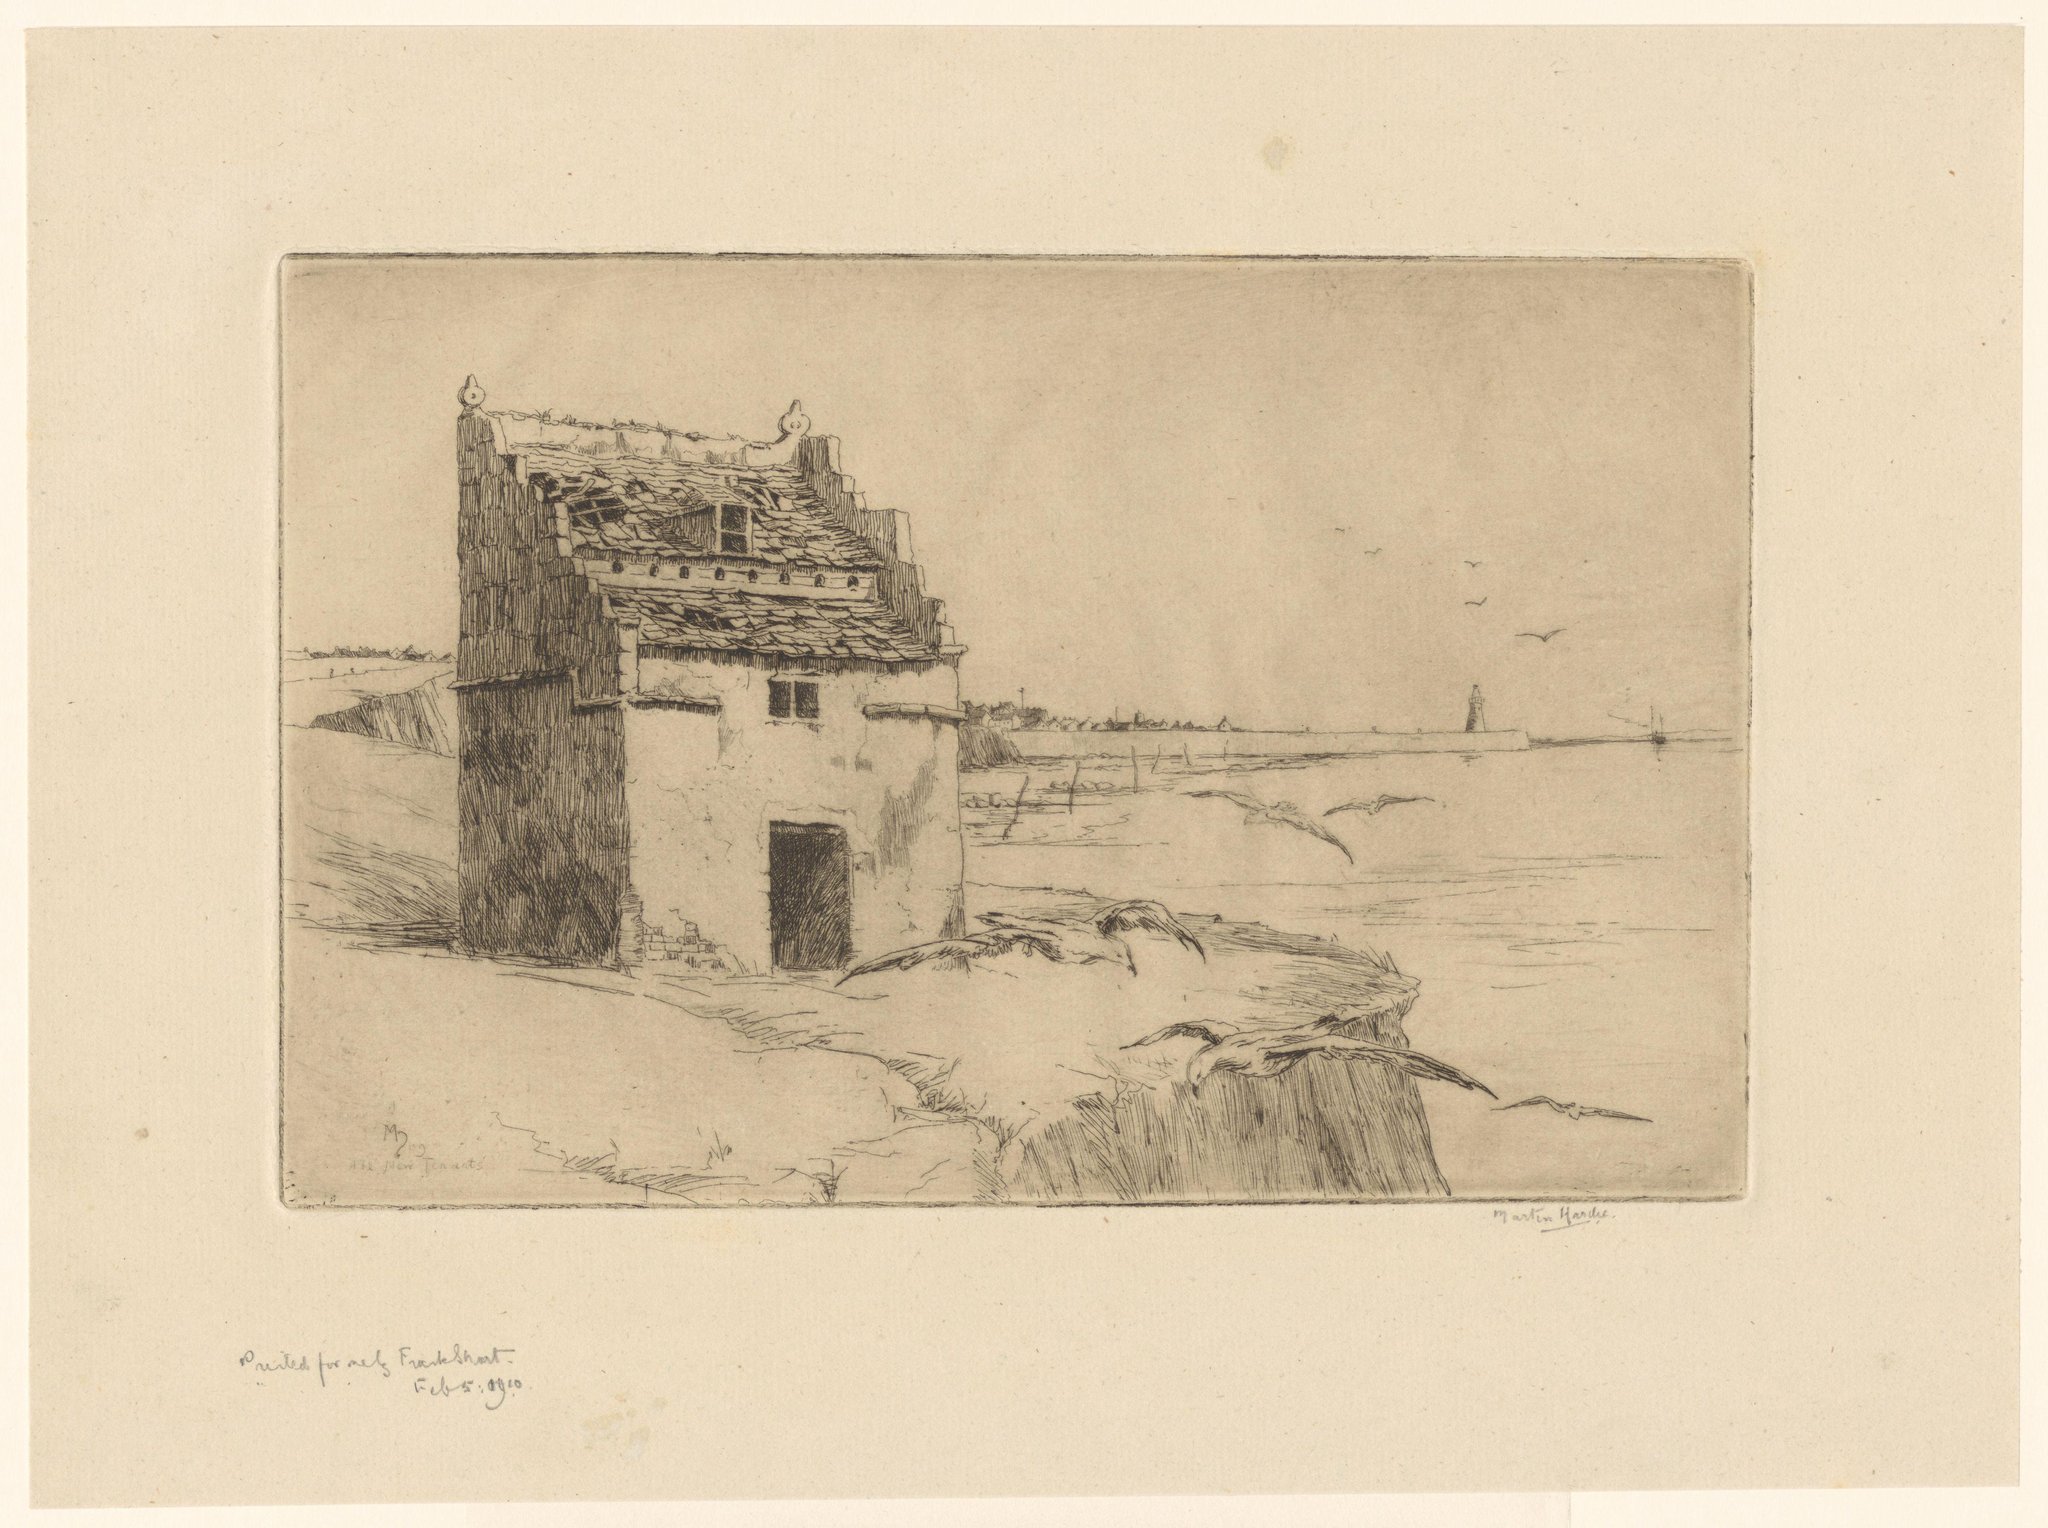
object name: print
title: Duiventil en de kust bij Anstruther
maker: martin hardie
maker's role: print maker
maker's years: 1875-1952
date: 1909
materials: paper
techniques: etching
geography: anstruther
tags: dove-cote, coast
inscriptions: collector's mark: Lugt 2760, annotation: ‘Martin Hardie’, collector's mark: Lugt 2228